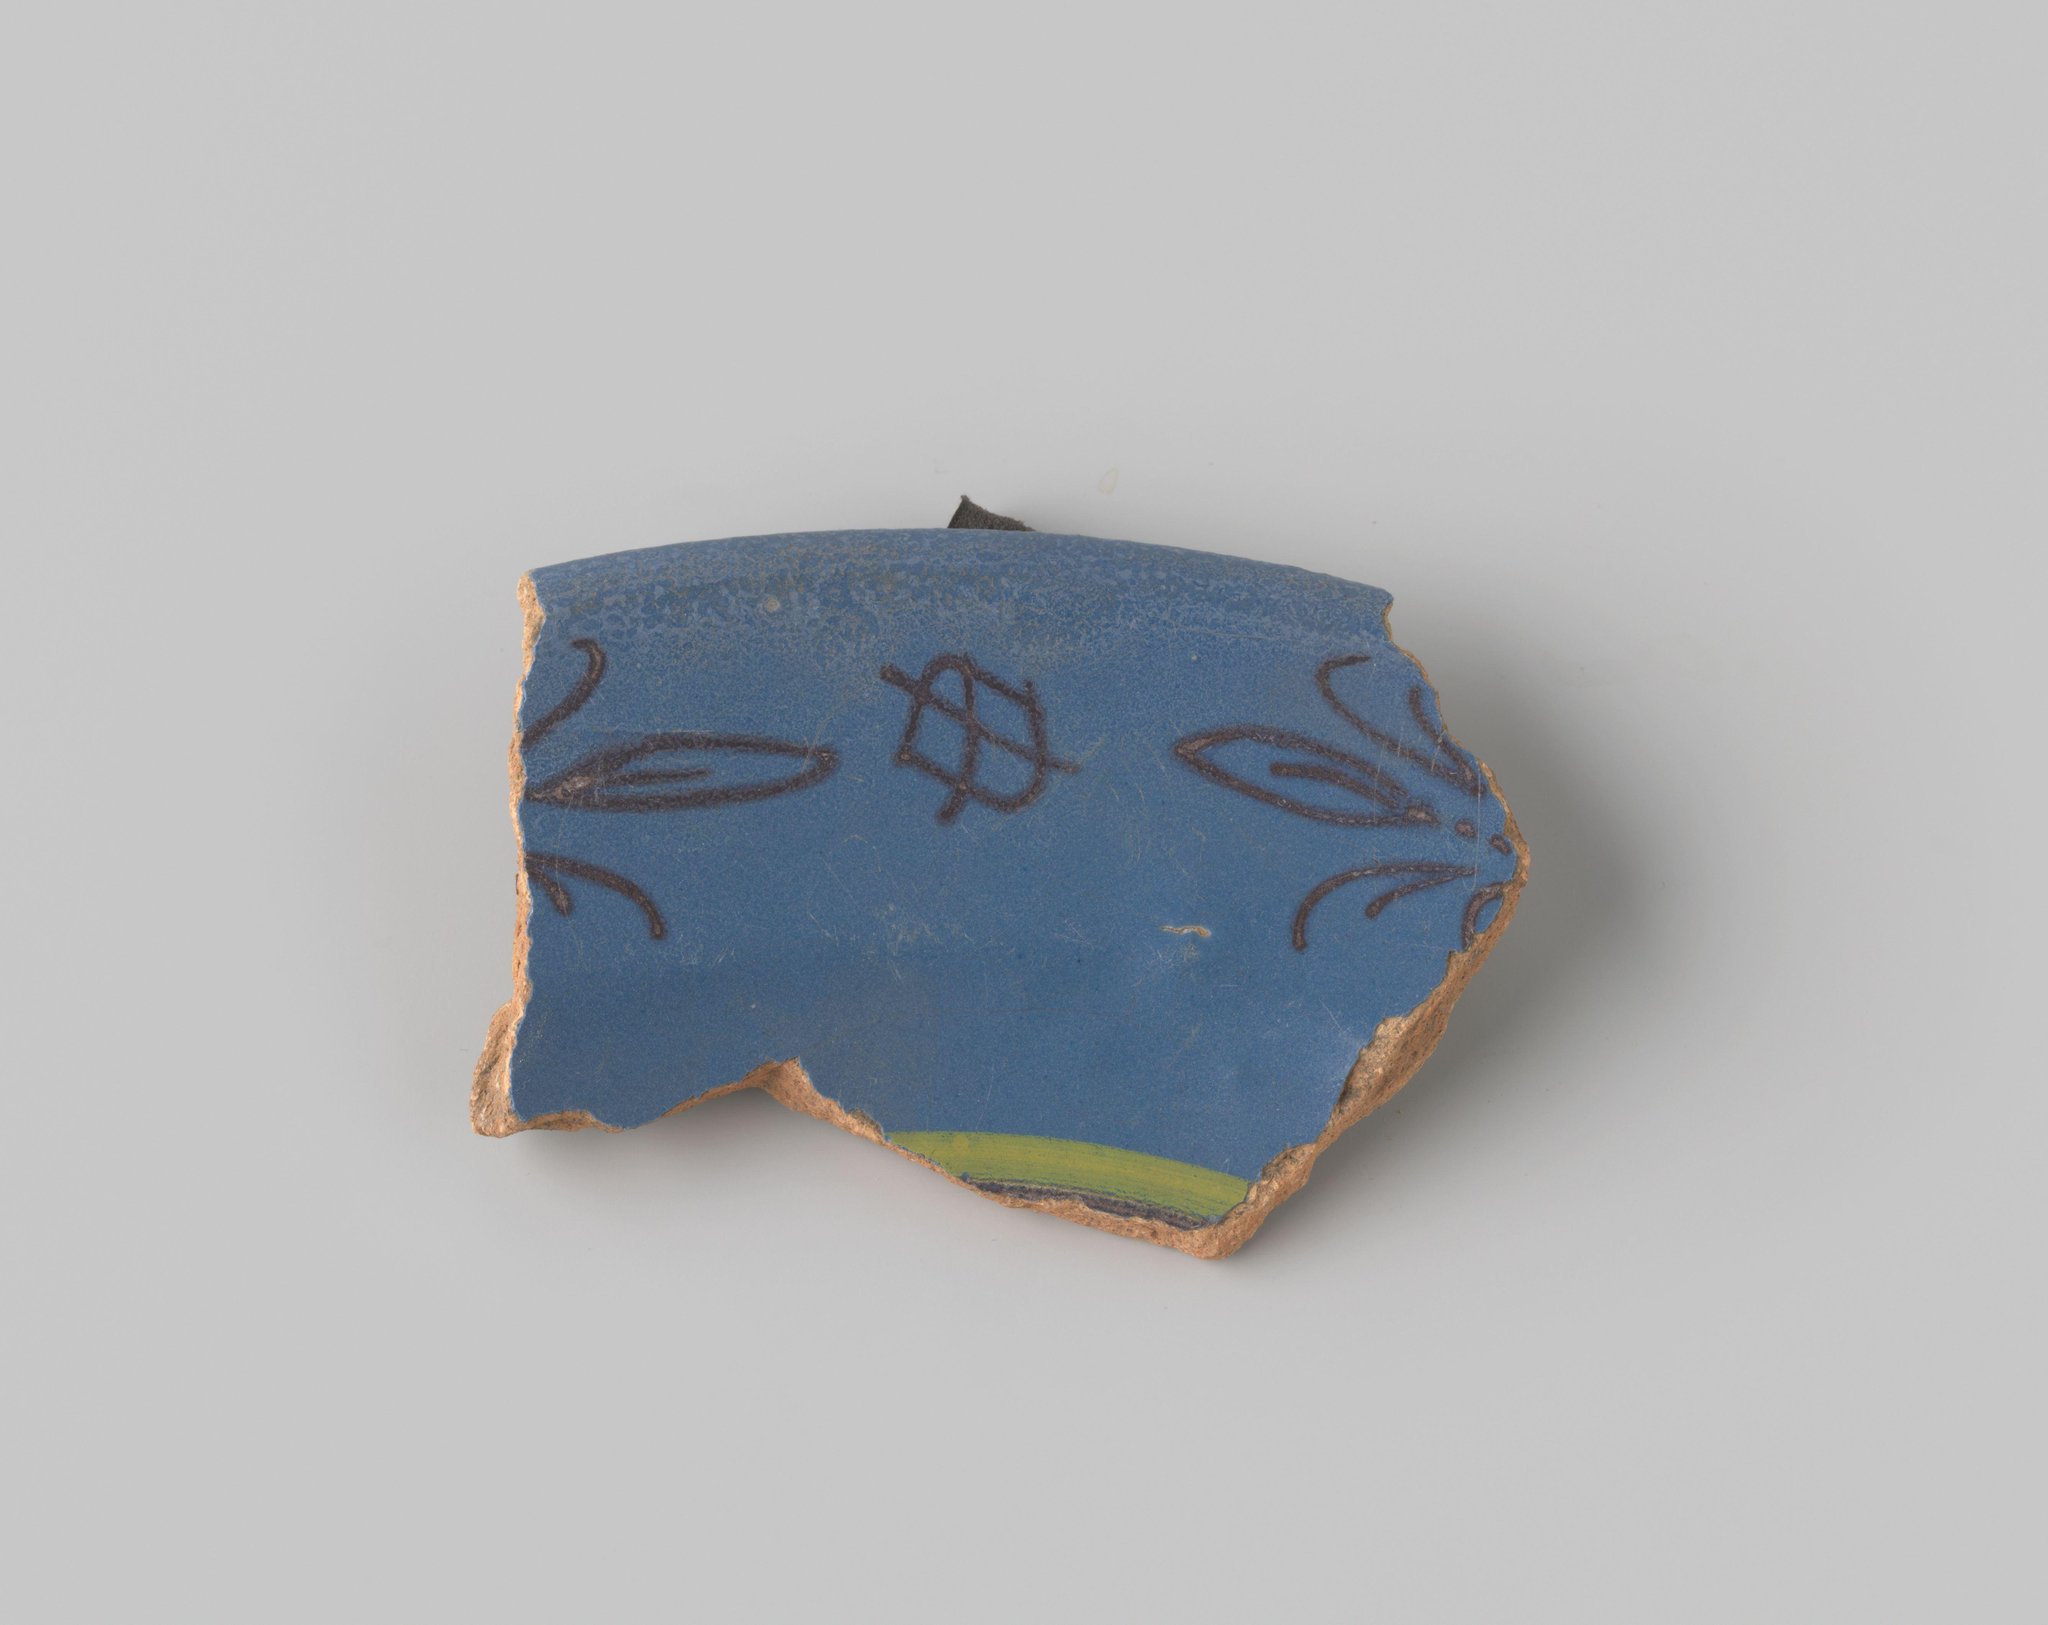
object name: sherd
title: Scherf van rossigbakkend aardewerk, aan de bovenzijde voorzien van blauw glazuur, waarop in bruin een ruit en gestildeerde bleomvormen zijn geschilderd, en een gele streep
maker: Anonymous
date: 1600-1650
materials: earthenware, glaze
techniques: maiolica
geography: northern netherlands